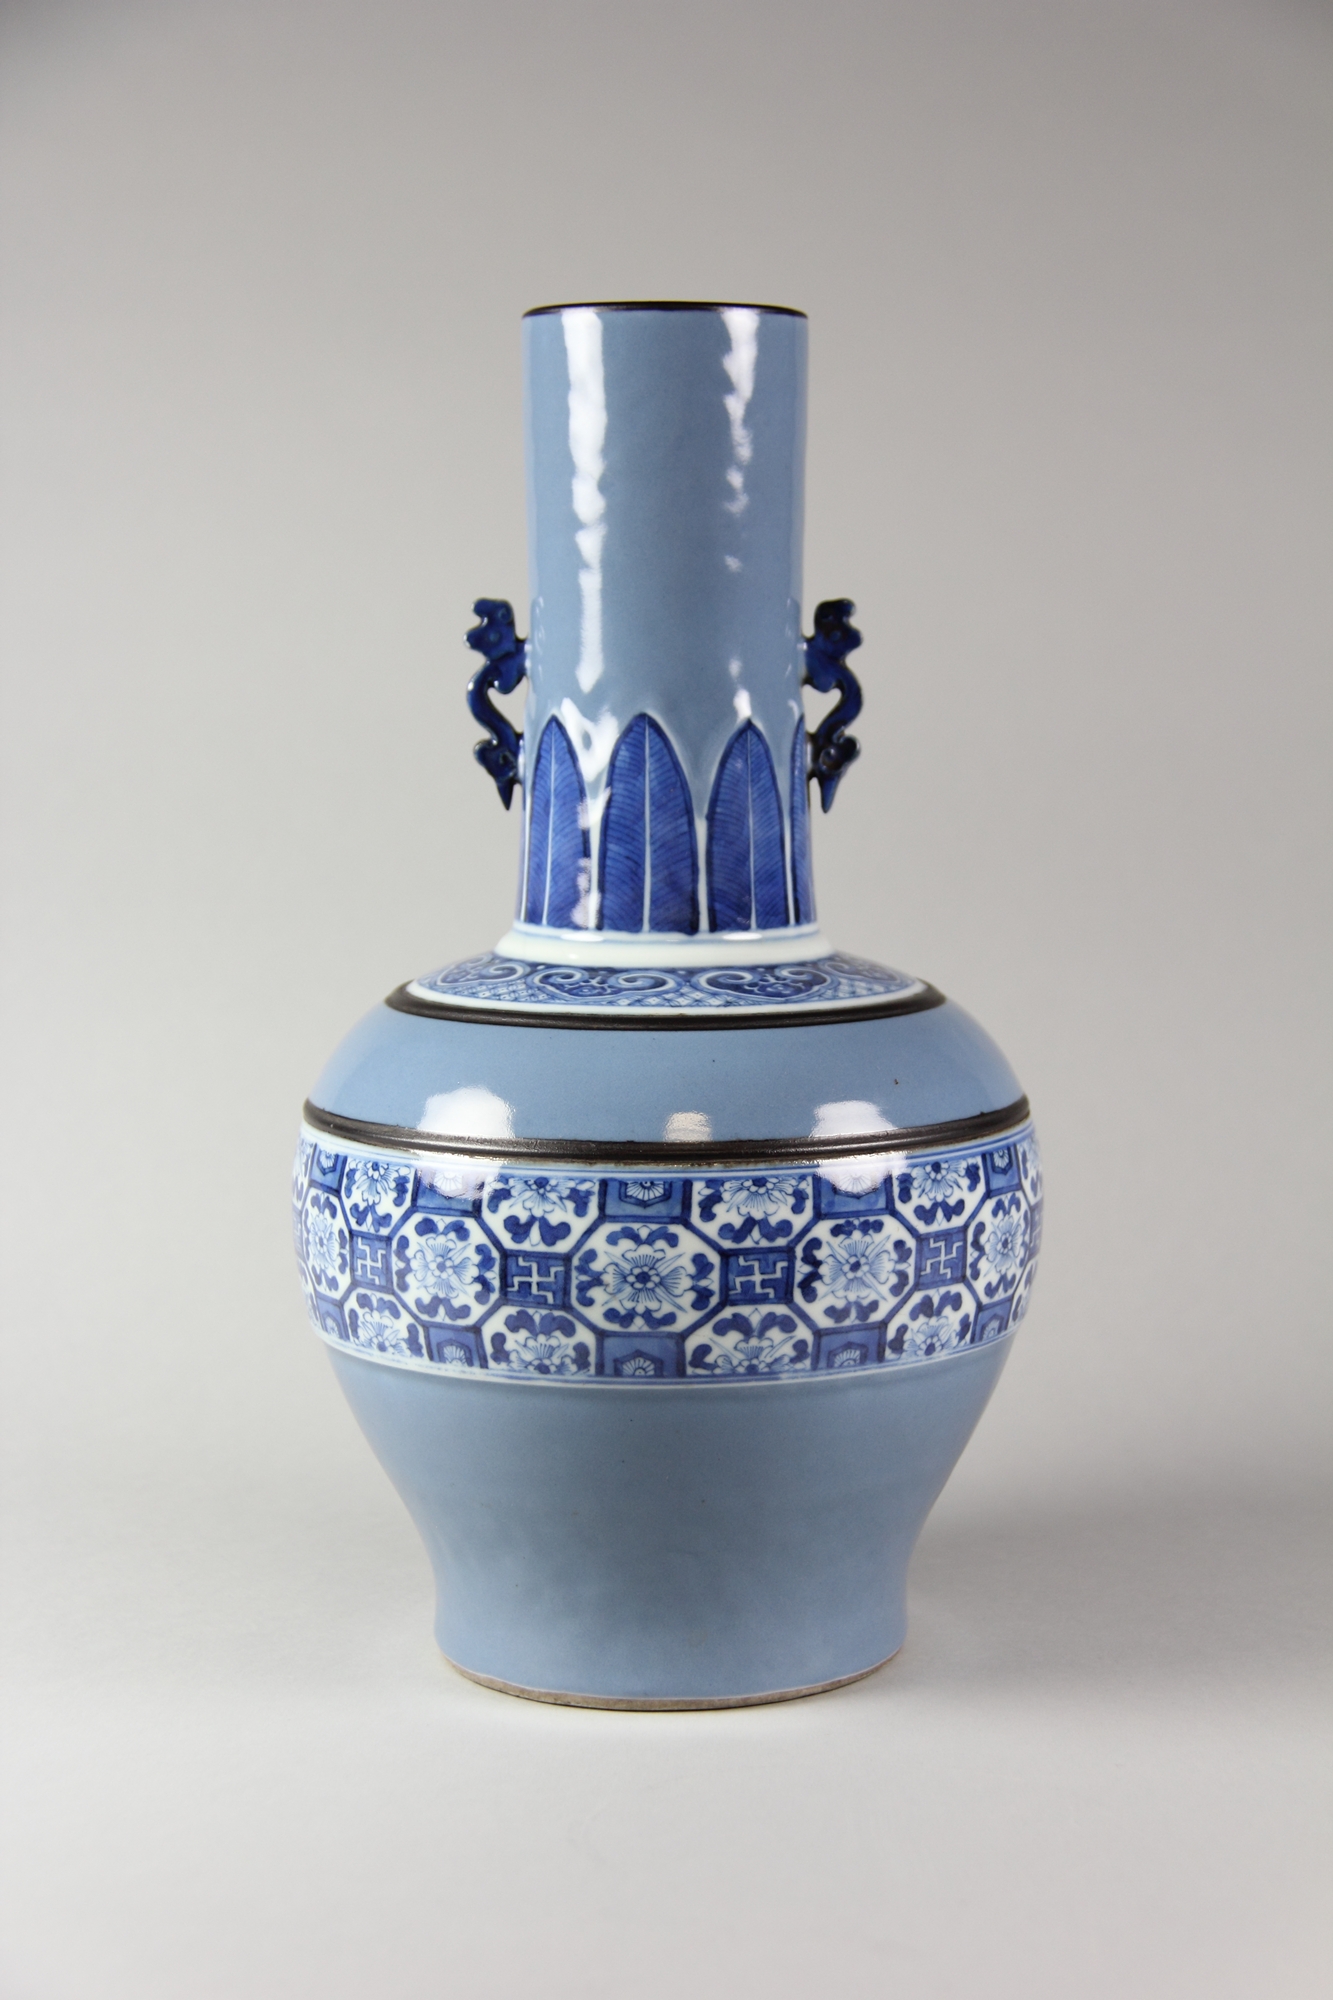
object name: vase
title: Vase with floral and geometric ornaments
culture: chinese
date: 1767-1800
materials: cobalt, glaze, porcelain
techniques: painting, underglaze